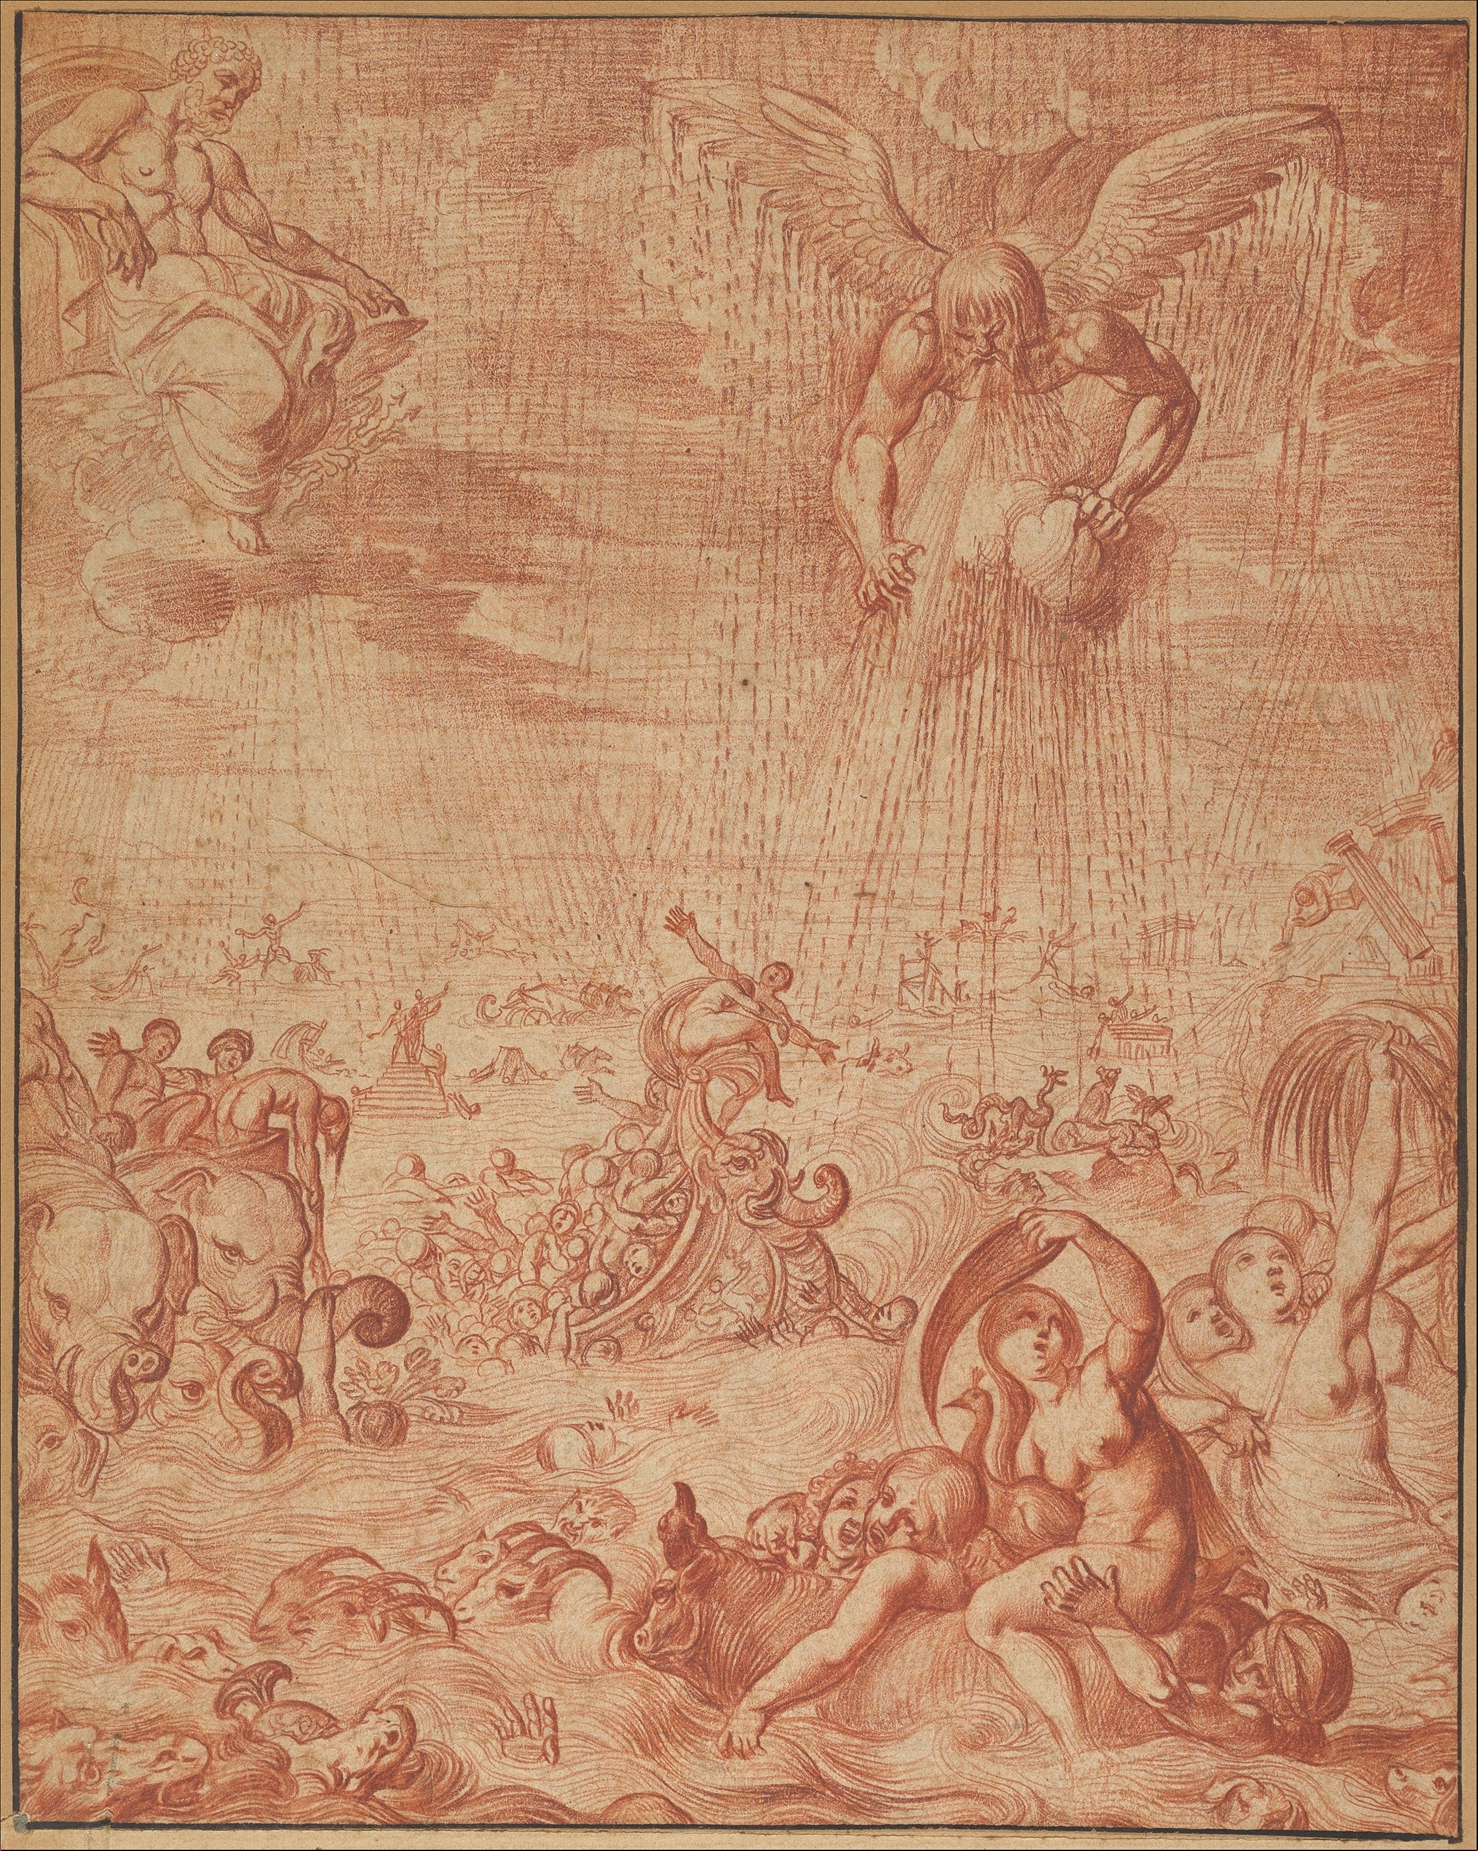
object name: drawing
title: The Deluge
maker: pierre brebiette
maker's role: artist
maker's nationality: french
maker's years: 1598-1642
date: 1630-1638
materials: chalk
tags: animals,suffering,female nudes,rain